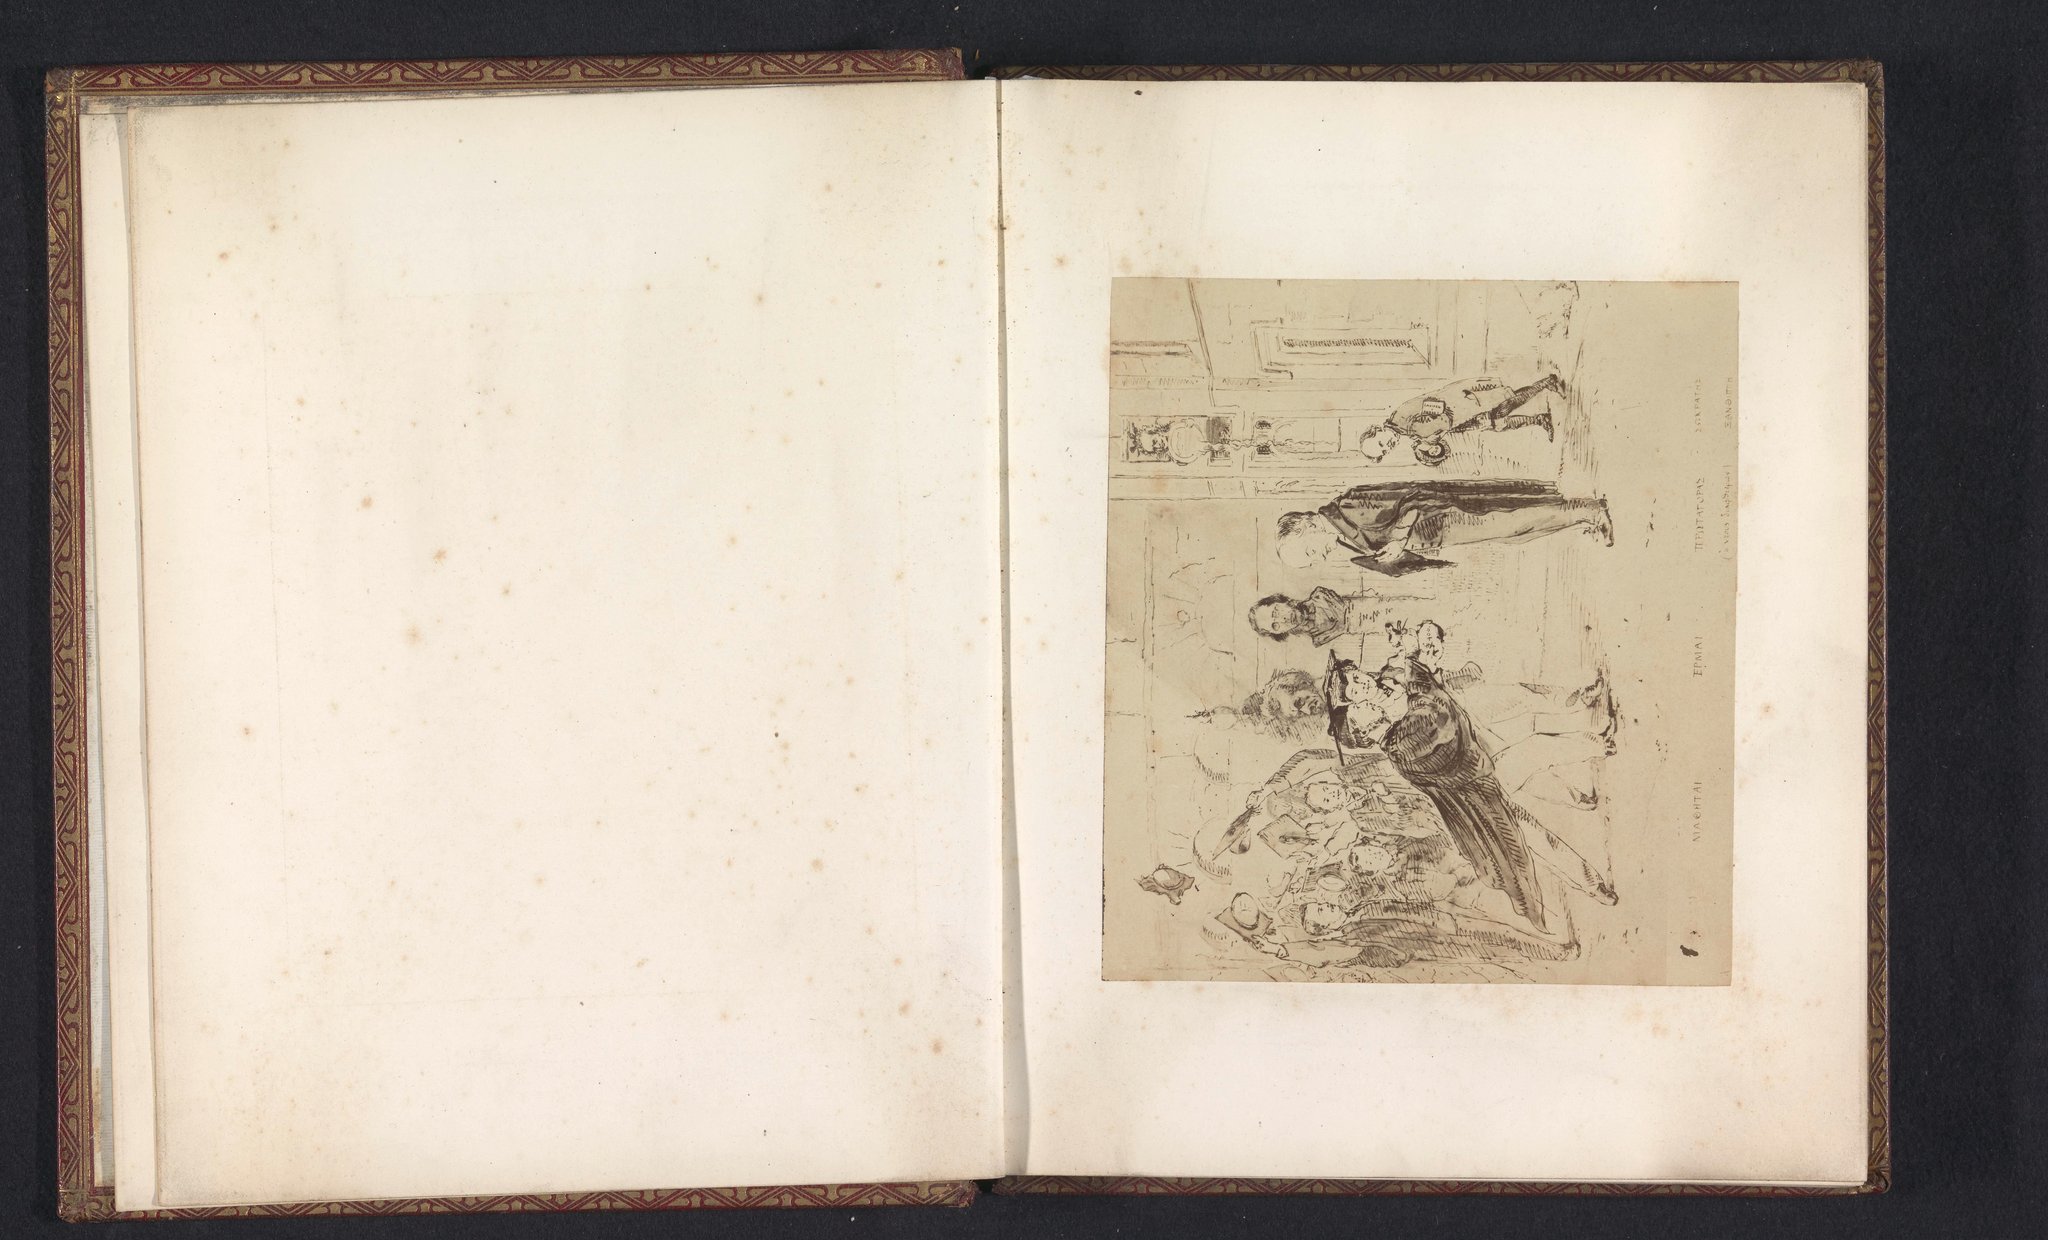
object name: page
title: Fotoreproductie van een tekening, voorstellende twee studenten bieden professor Jowett een geldzak aan ter verhoging van zijn salaris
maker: Anonymous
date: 1855-1866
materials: photographic support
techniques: albumen print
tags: purse, money-bag, caricatures (human types), professor, student life